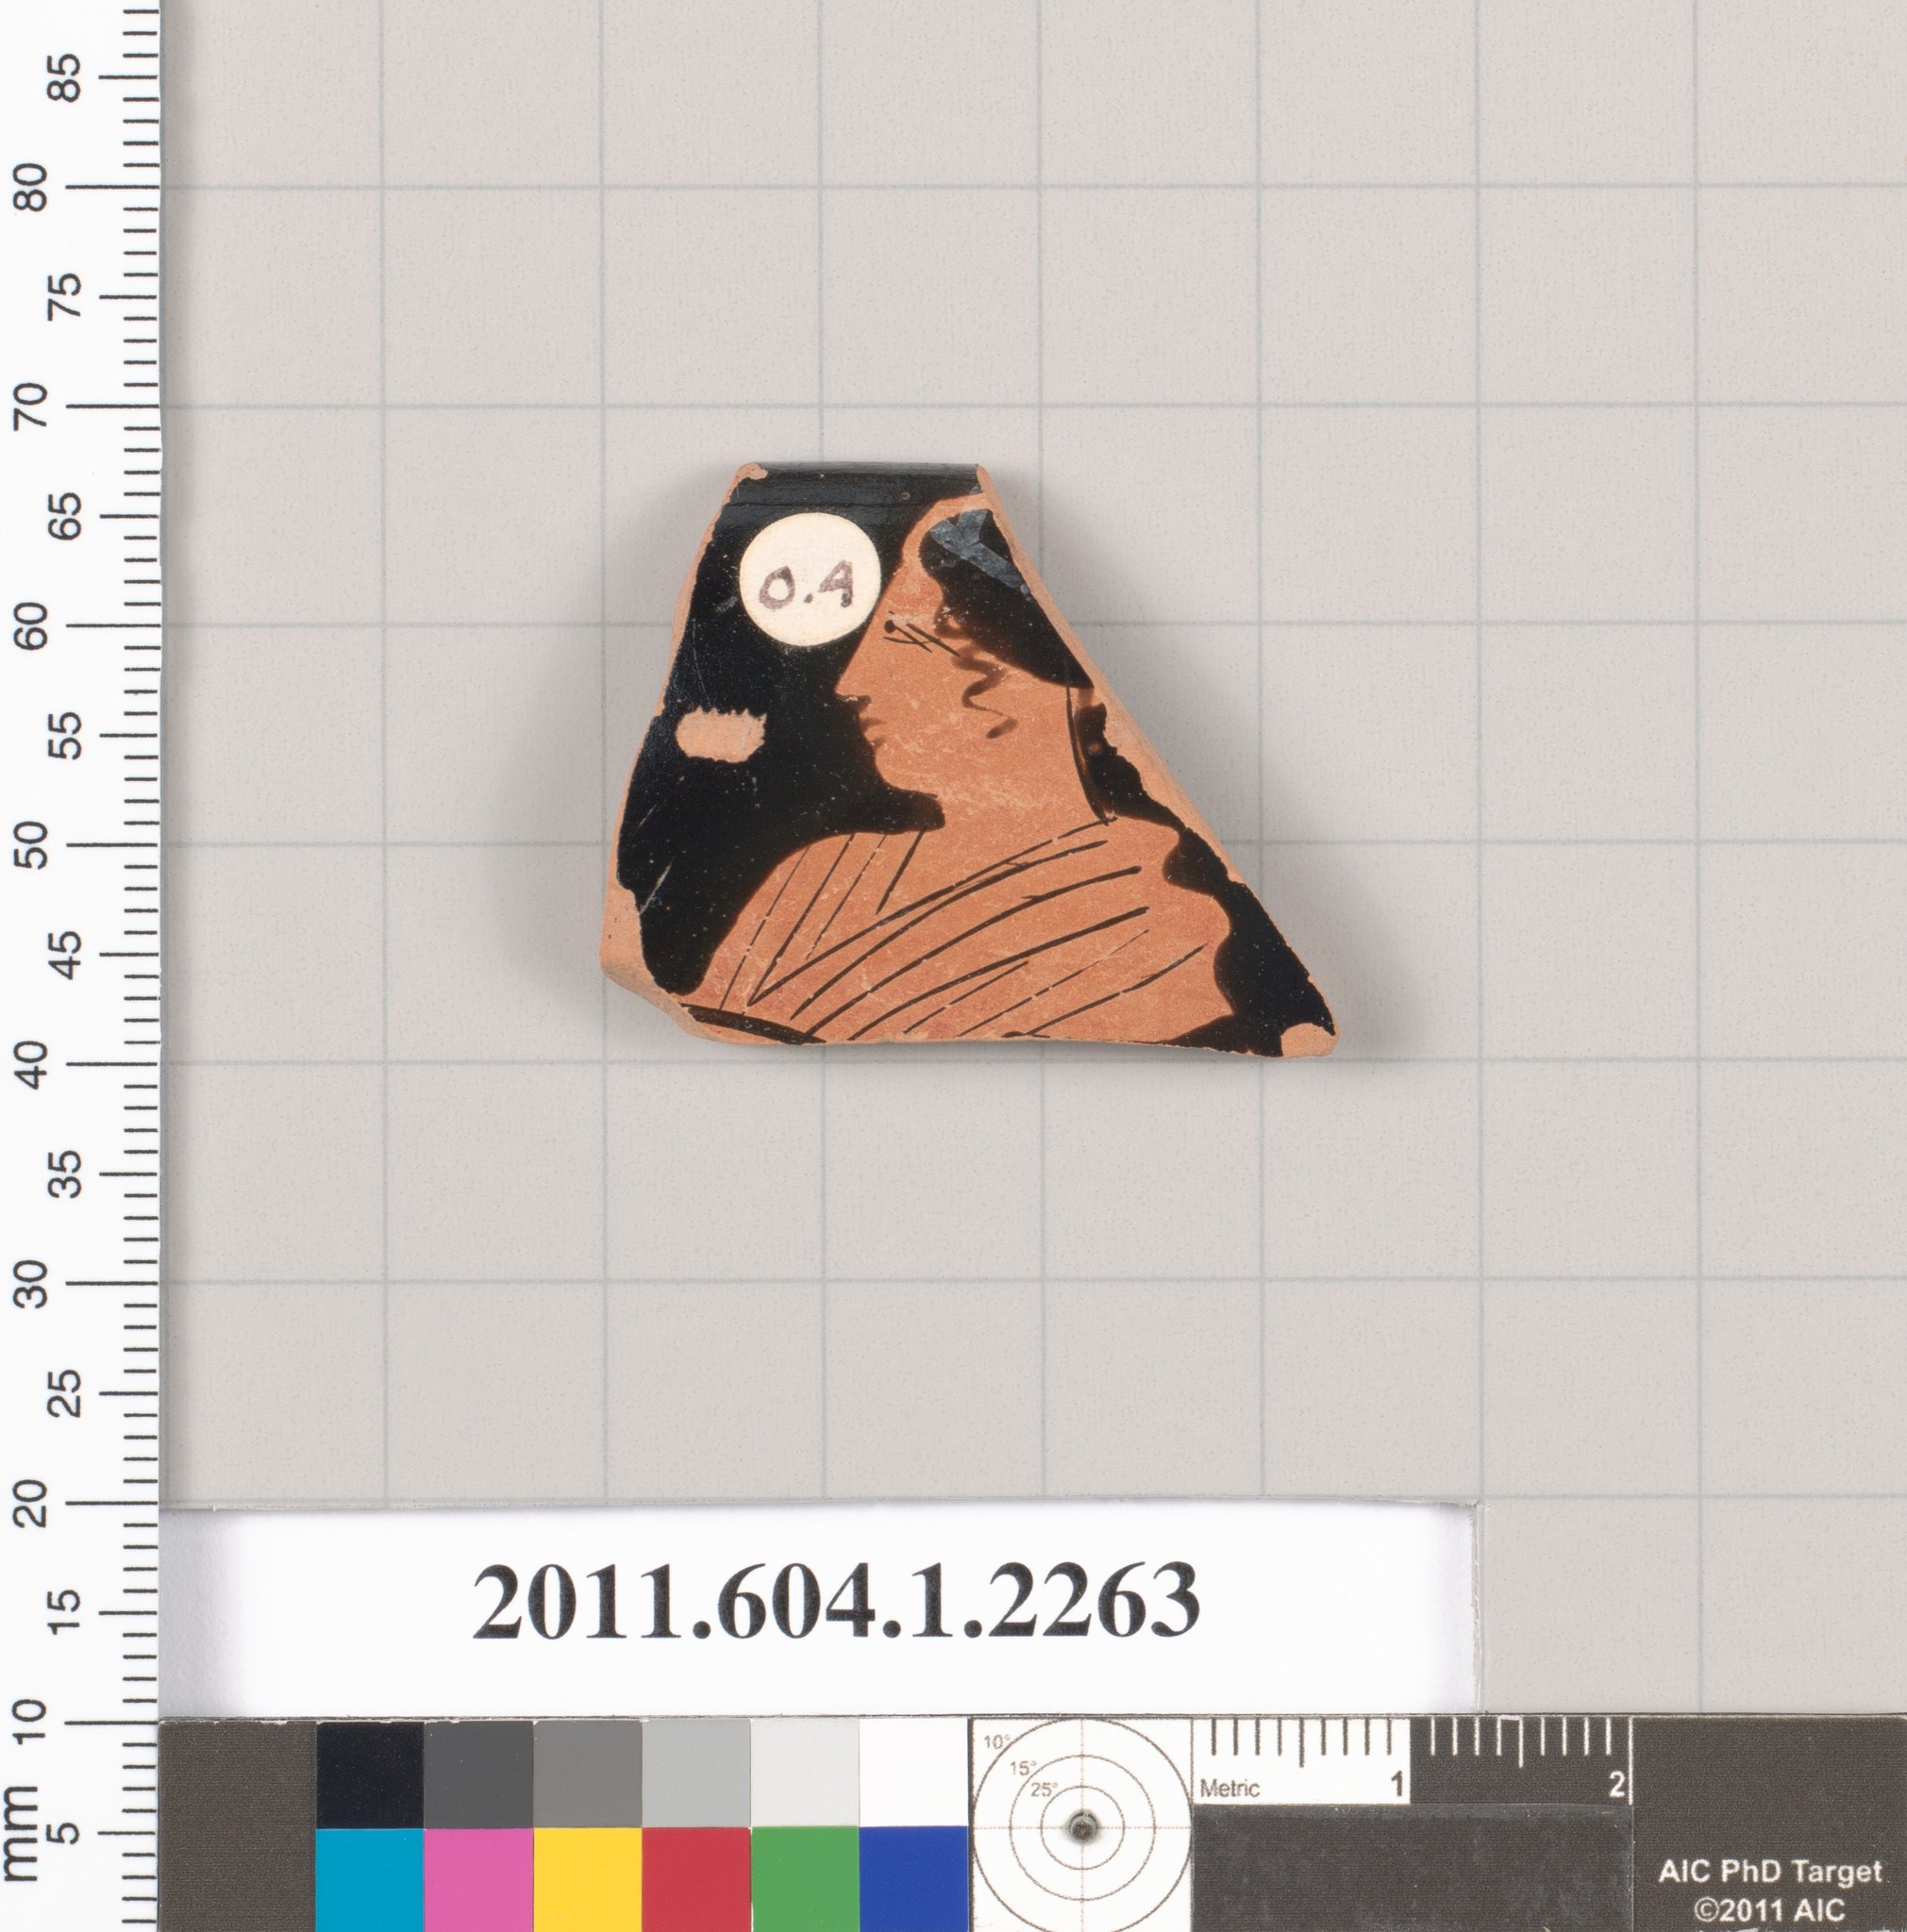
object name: kylix fragment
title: Terracotta rim fragment of a kylix (drinking cup)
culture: greek, attic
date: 467-435 BCE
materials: terracotta